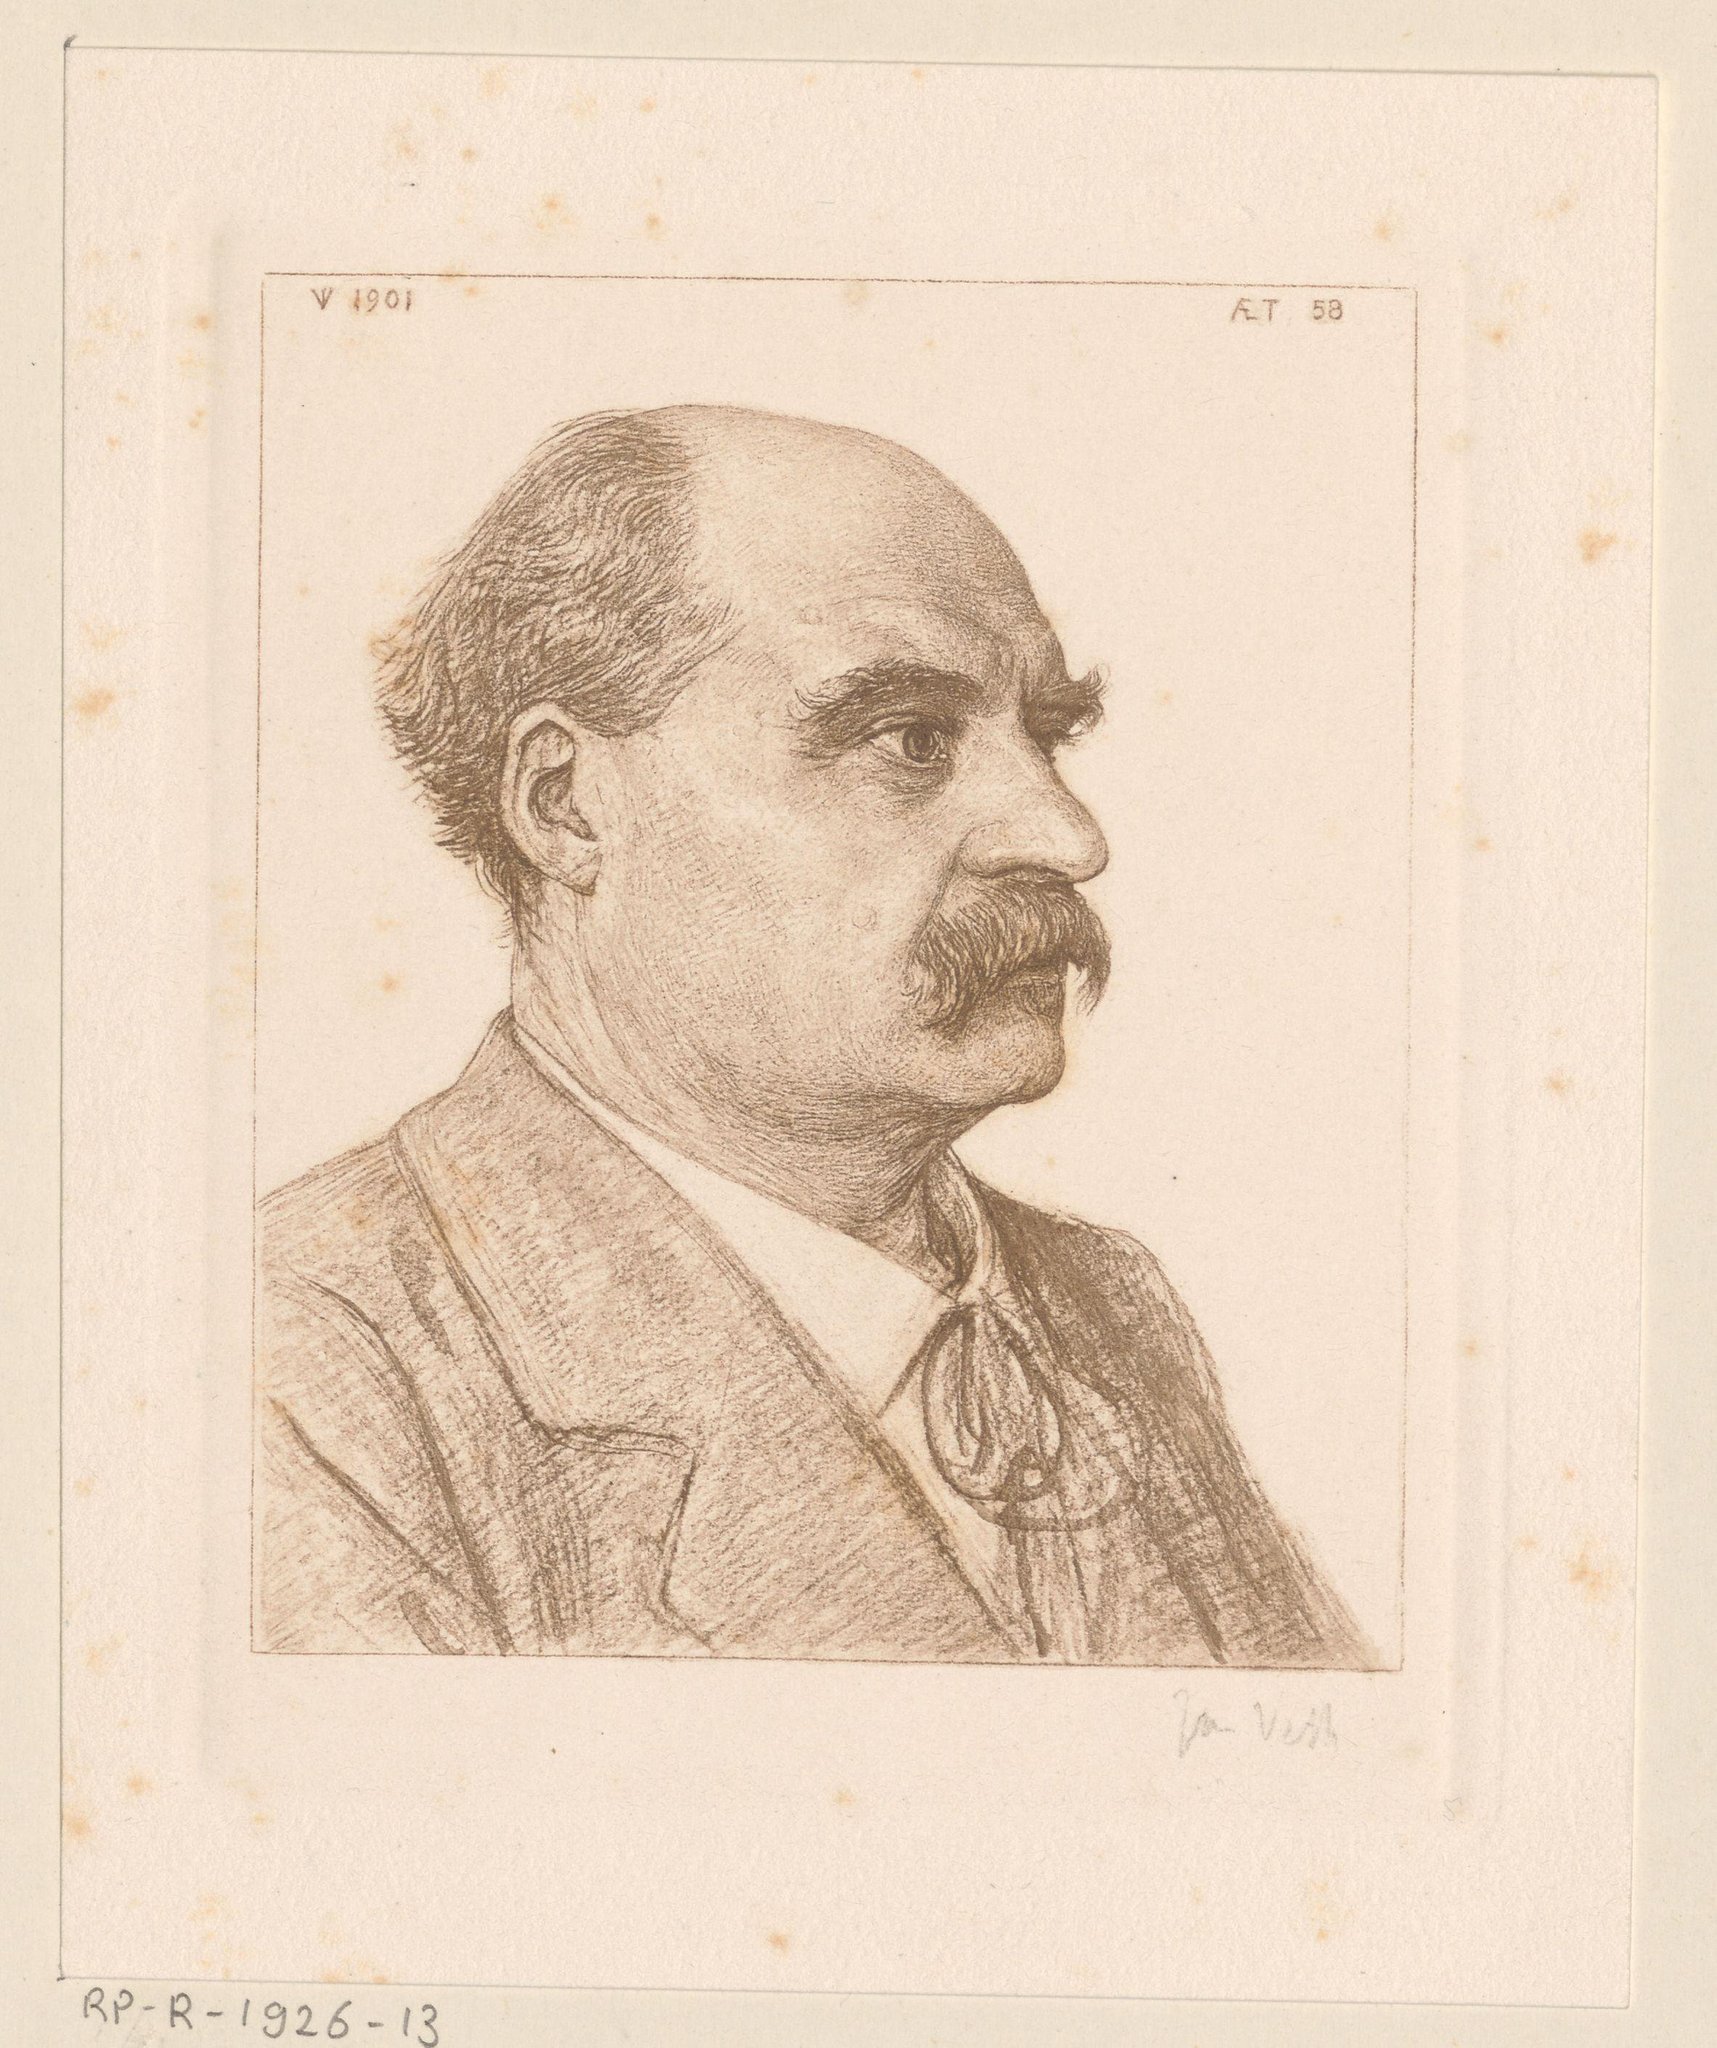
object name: reproduction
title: Portret van Henri van der Hoeven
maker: Anonymous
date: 1901-1915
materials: paper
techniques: photoaquatint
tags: historical persons